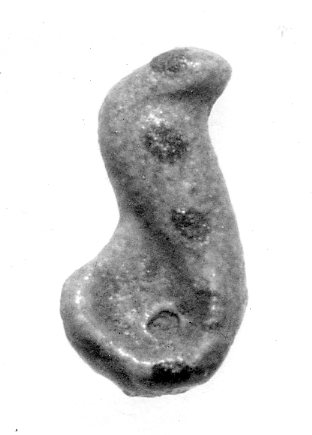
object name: amulet, cobra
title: Cobra amulet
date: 400-30 BCE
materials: glass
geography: egypt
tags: snakes